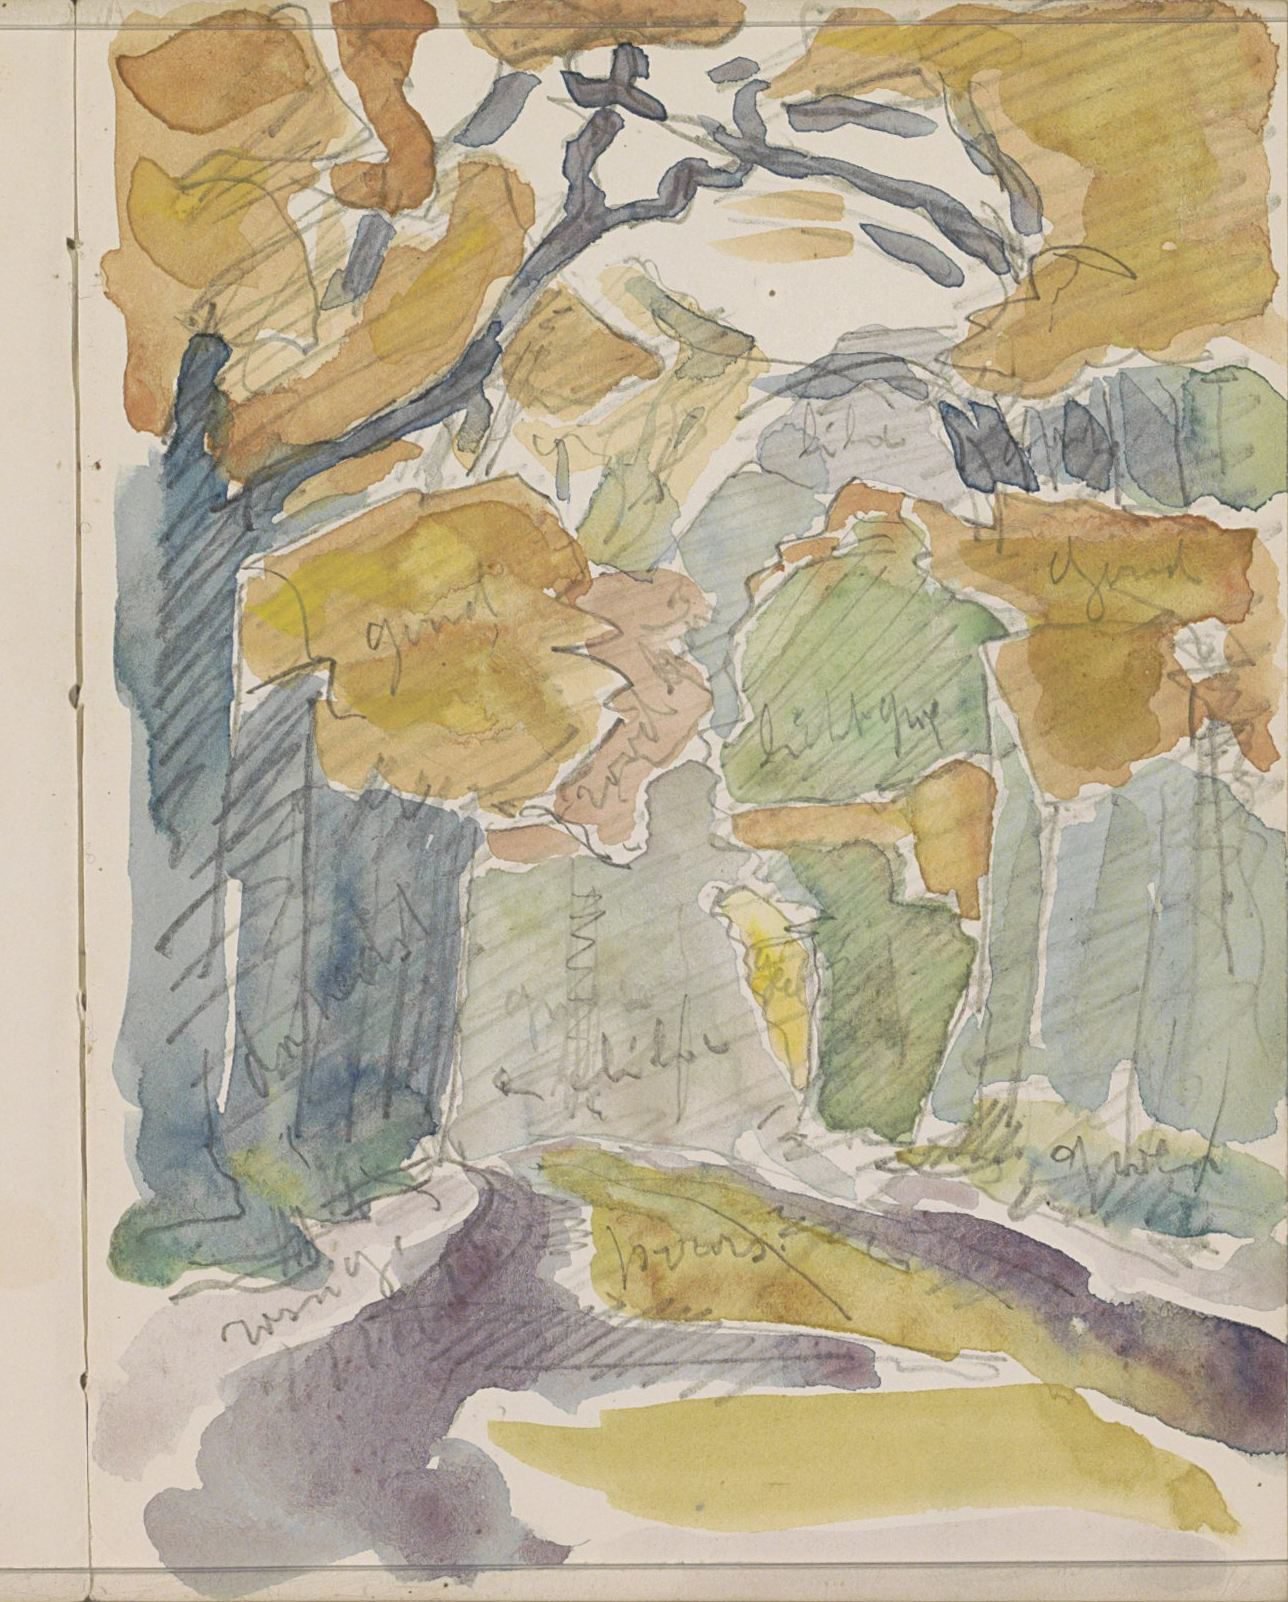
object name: sketchbook leaf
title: Bospad in de herfst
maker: reijer stolk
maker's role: draughtsman, print maker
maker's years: 1896-1945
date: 1916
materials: paper, pencil, watercolor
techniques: brush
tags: forest path or lane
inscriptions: kleurnotitie, handgeschreven in potlood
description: Blad 62 recto uit een schetsboek met 72 bladen.